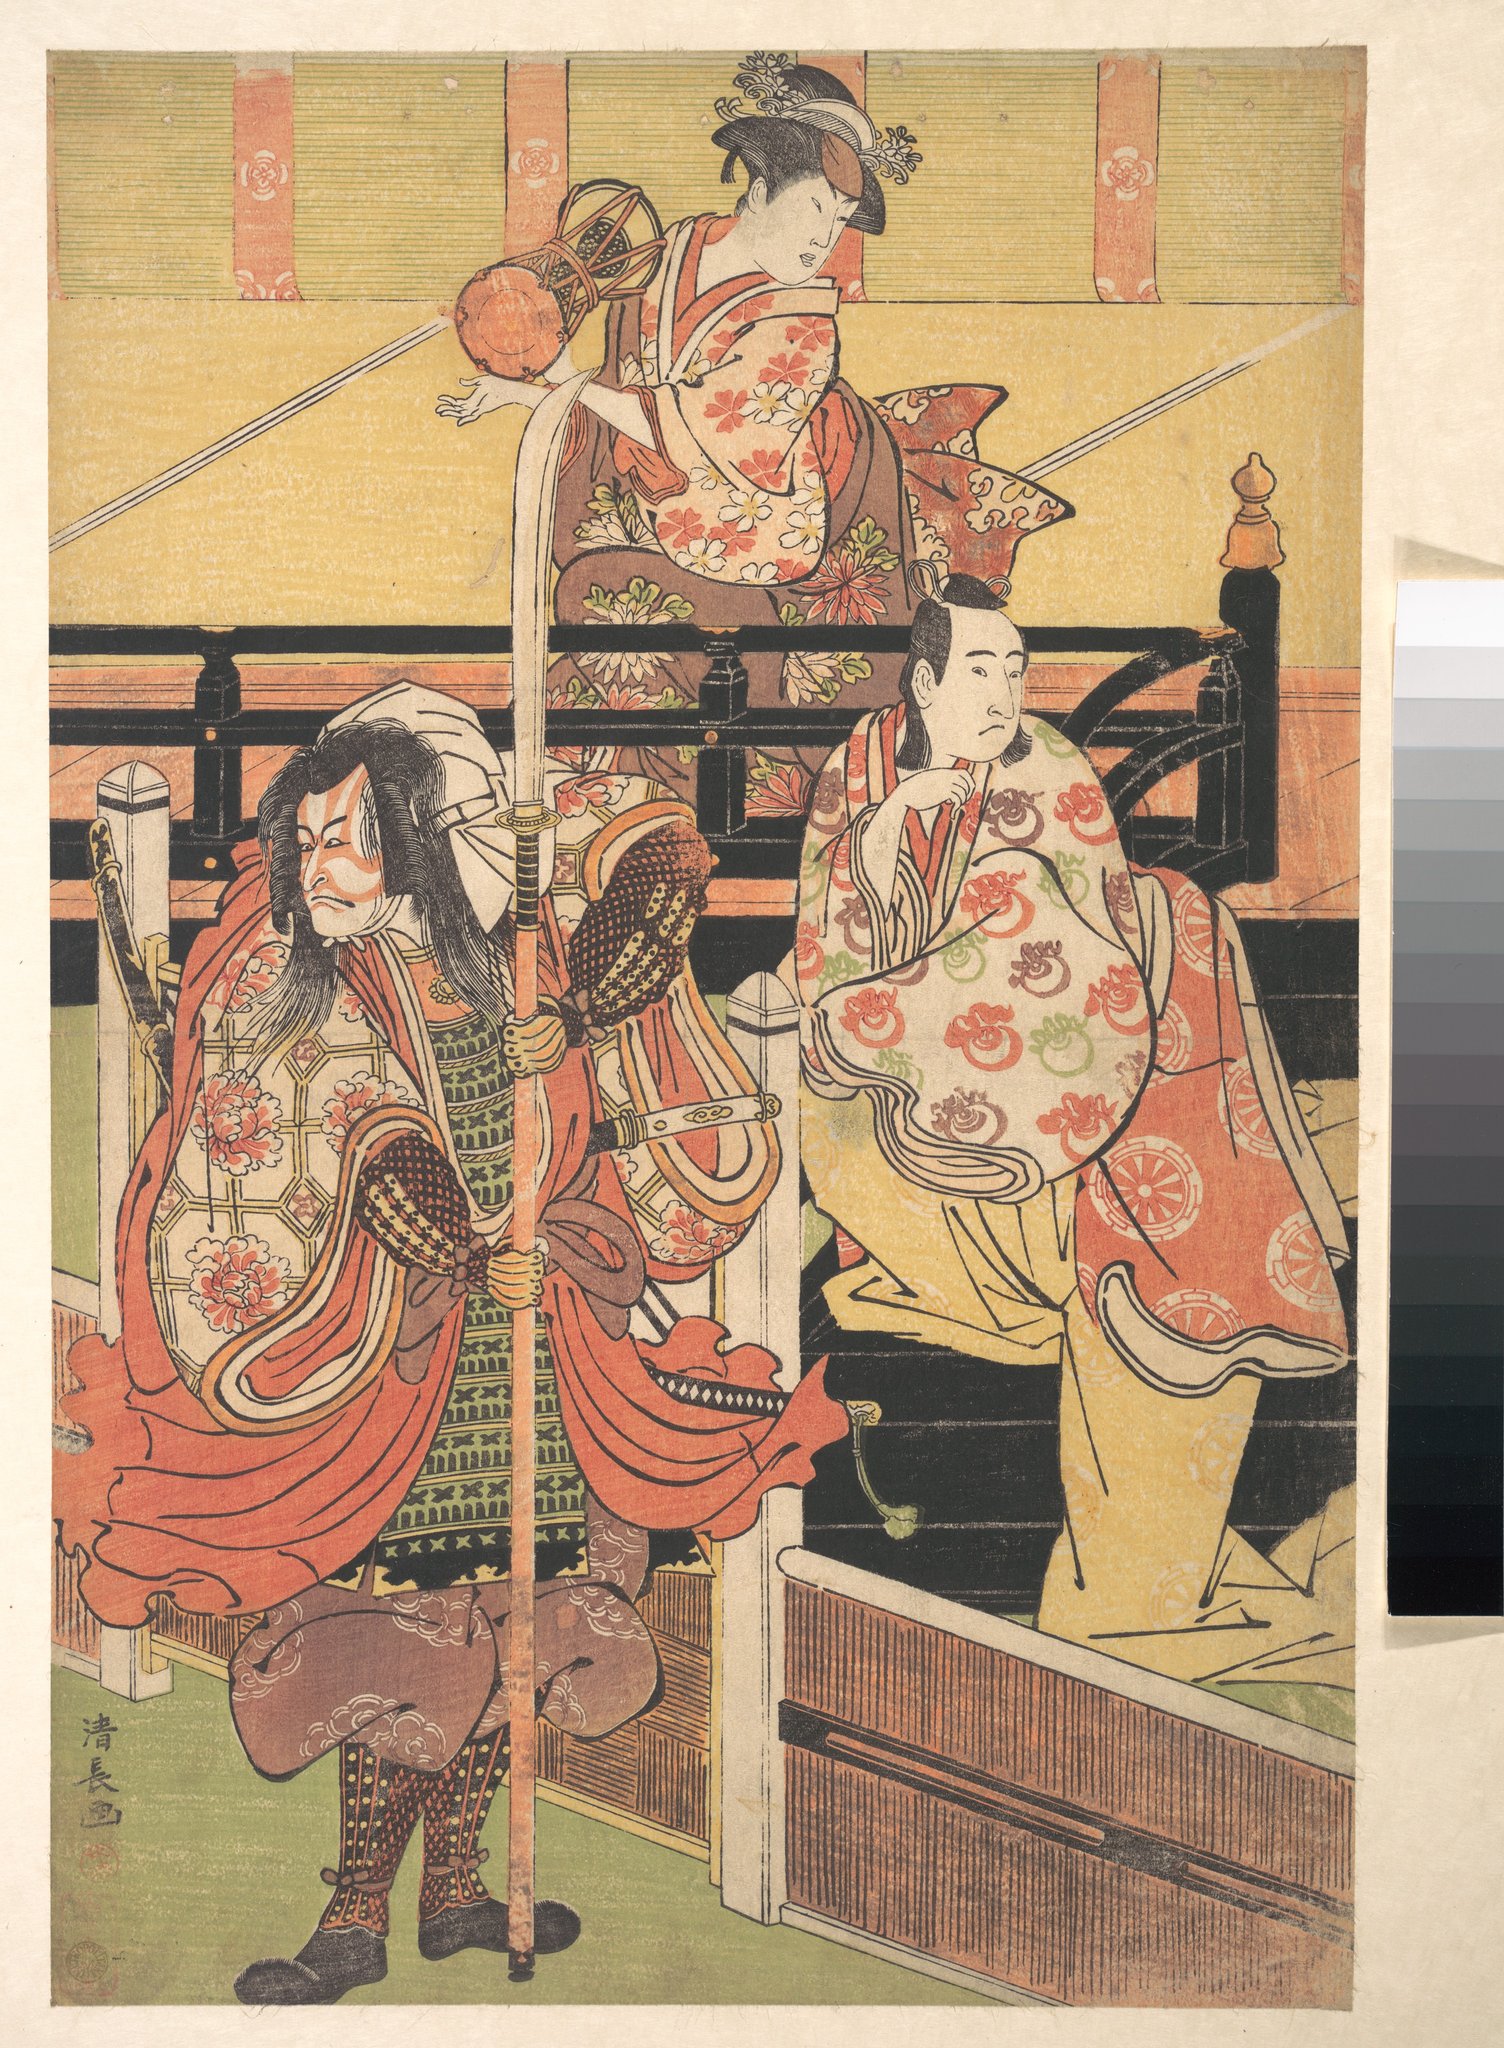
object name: woodblock print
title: On a Balcony a Woman is Seated Playing a Tsuzumi, below a Man in Daimyo Costume is Seated upon a Black Lacquer Box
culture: japanese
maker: torii kiyonaga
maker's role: artist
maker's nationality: japanese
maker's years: 1752-1815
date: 1790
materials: ink, paper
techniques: woodblock print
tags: men,women,drums